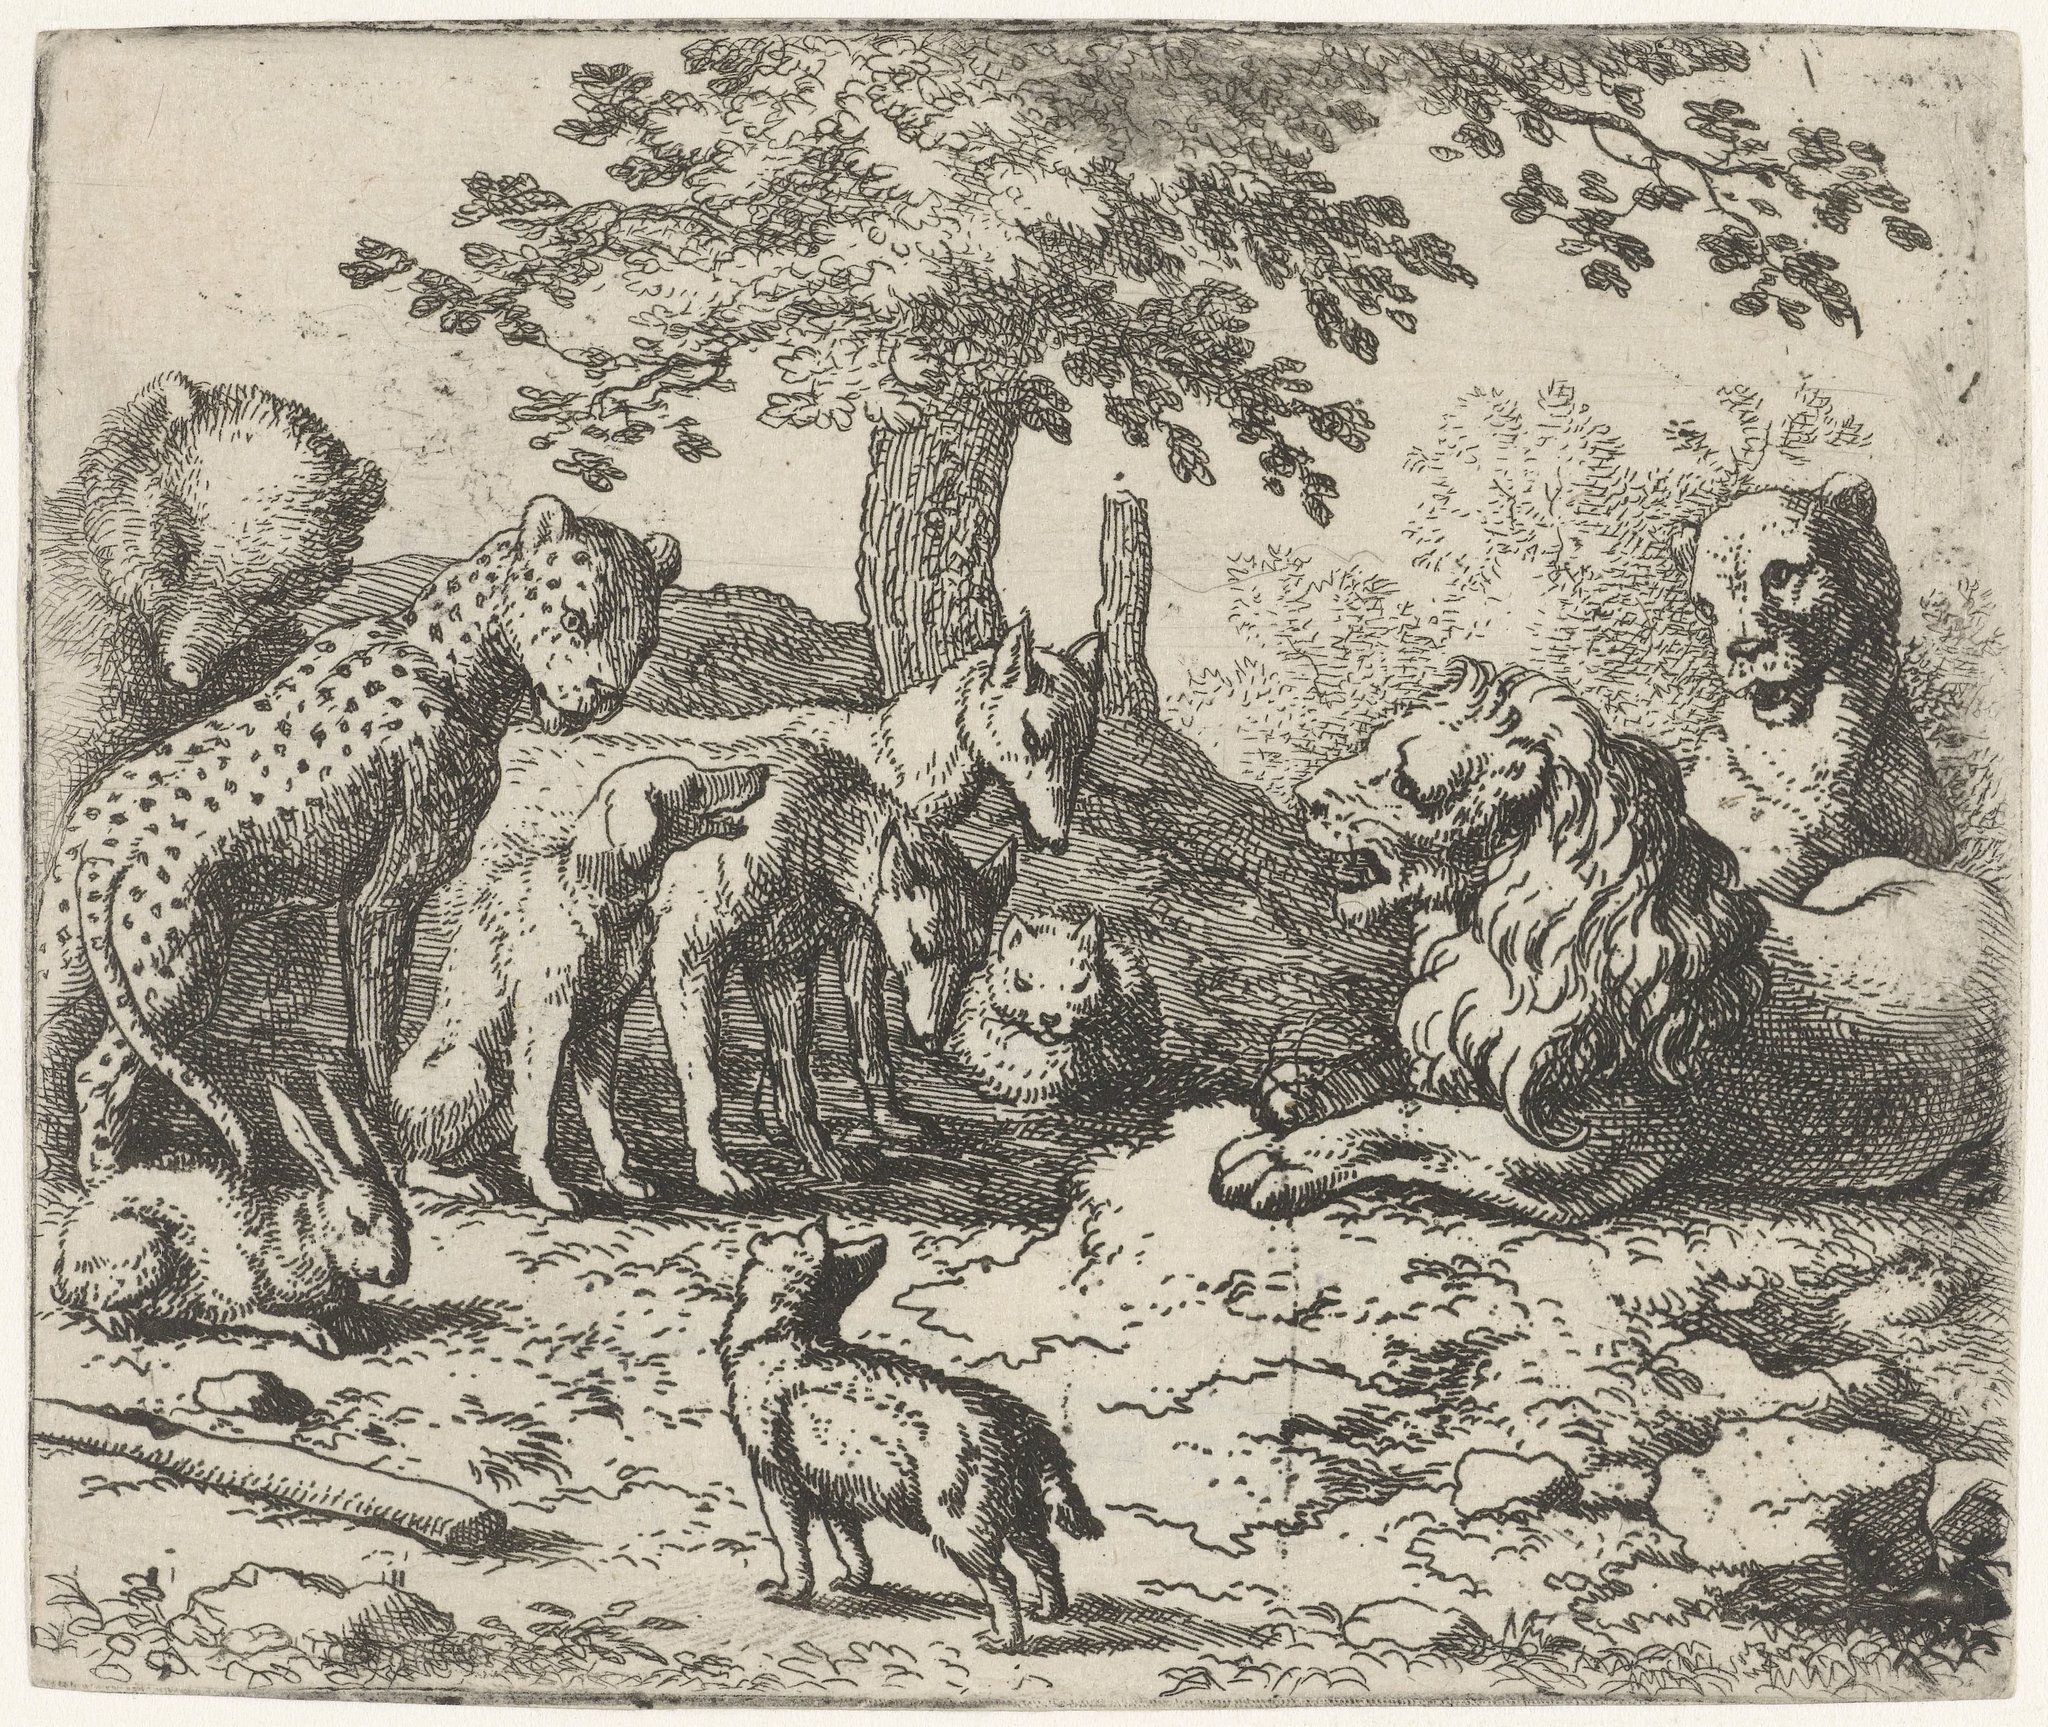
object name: print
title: Beraad van koning Nobel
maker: allaert van everdingen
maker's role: draughtsman, painter, print maker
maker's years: 1621-1675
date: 1665-1675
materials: paper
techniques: etching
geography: netherlands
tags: fable of reynard the fox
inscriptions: collector's mark: Lugt 2228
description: De leeuw, koning Nobel, beraadslaagt met de andere dieren, waaronder Fyrapeel het luipaard, Bruun de beer en Cuwaert het konijn.